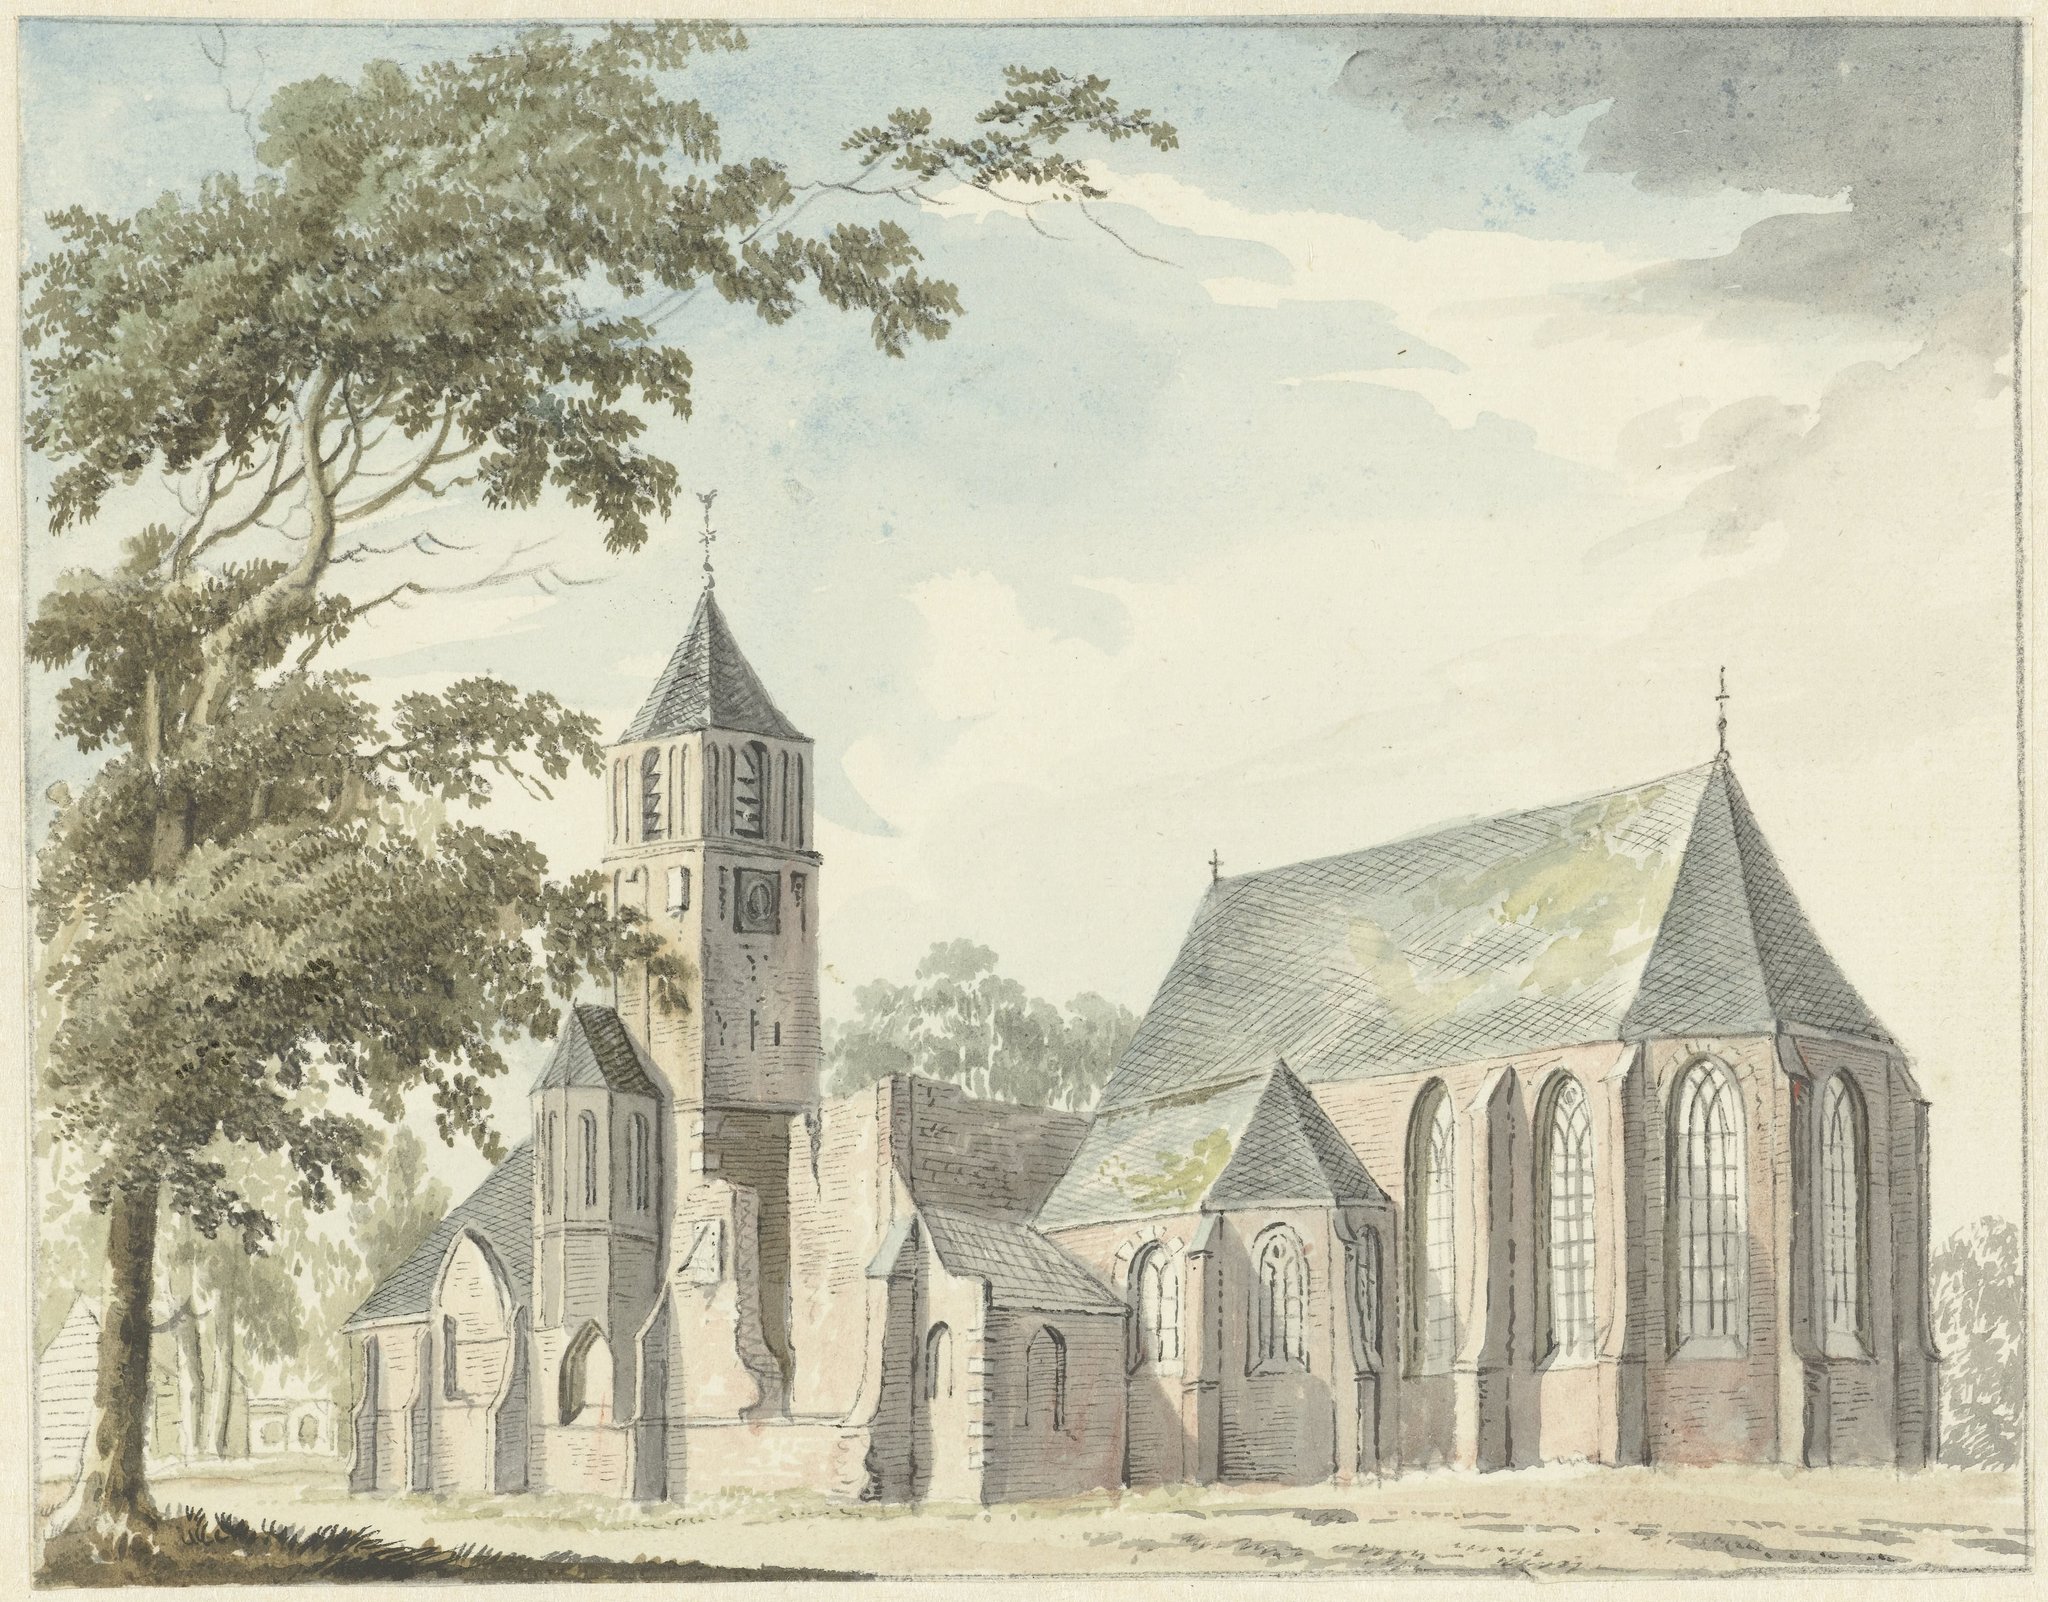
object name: drawing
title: Kerk te Warmond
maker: hendrik tavenier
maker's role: draughtsman, print maker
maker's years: 1734-1807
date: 1783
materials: ink, paper, watercolor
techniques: brush, pen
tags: church (exterior), ruin of church, monastery, etc., warmond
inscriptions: inscription: ‘de kerk te Warmont 1783 / H: Tavenier’